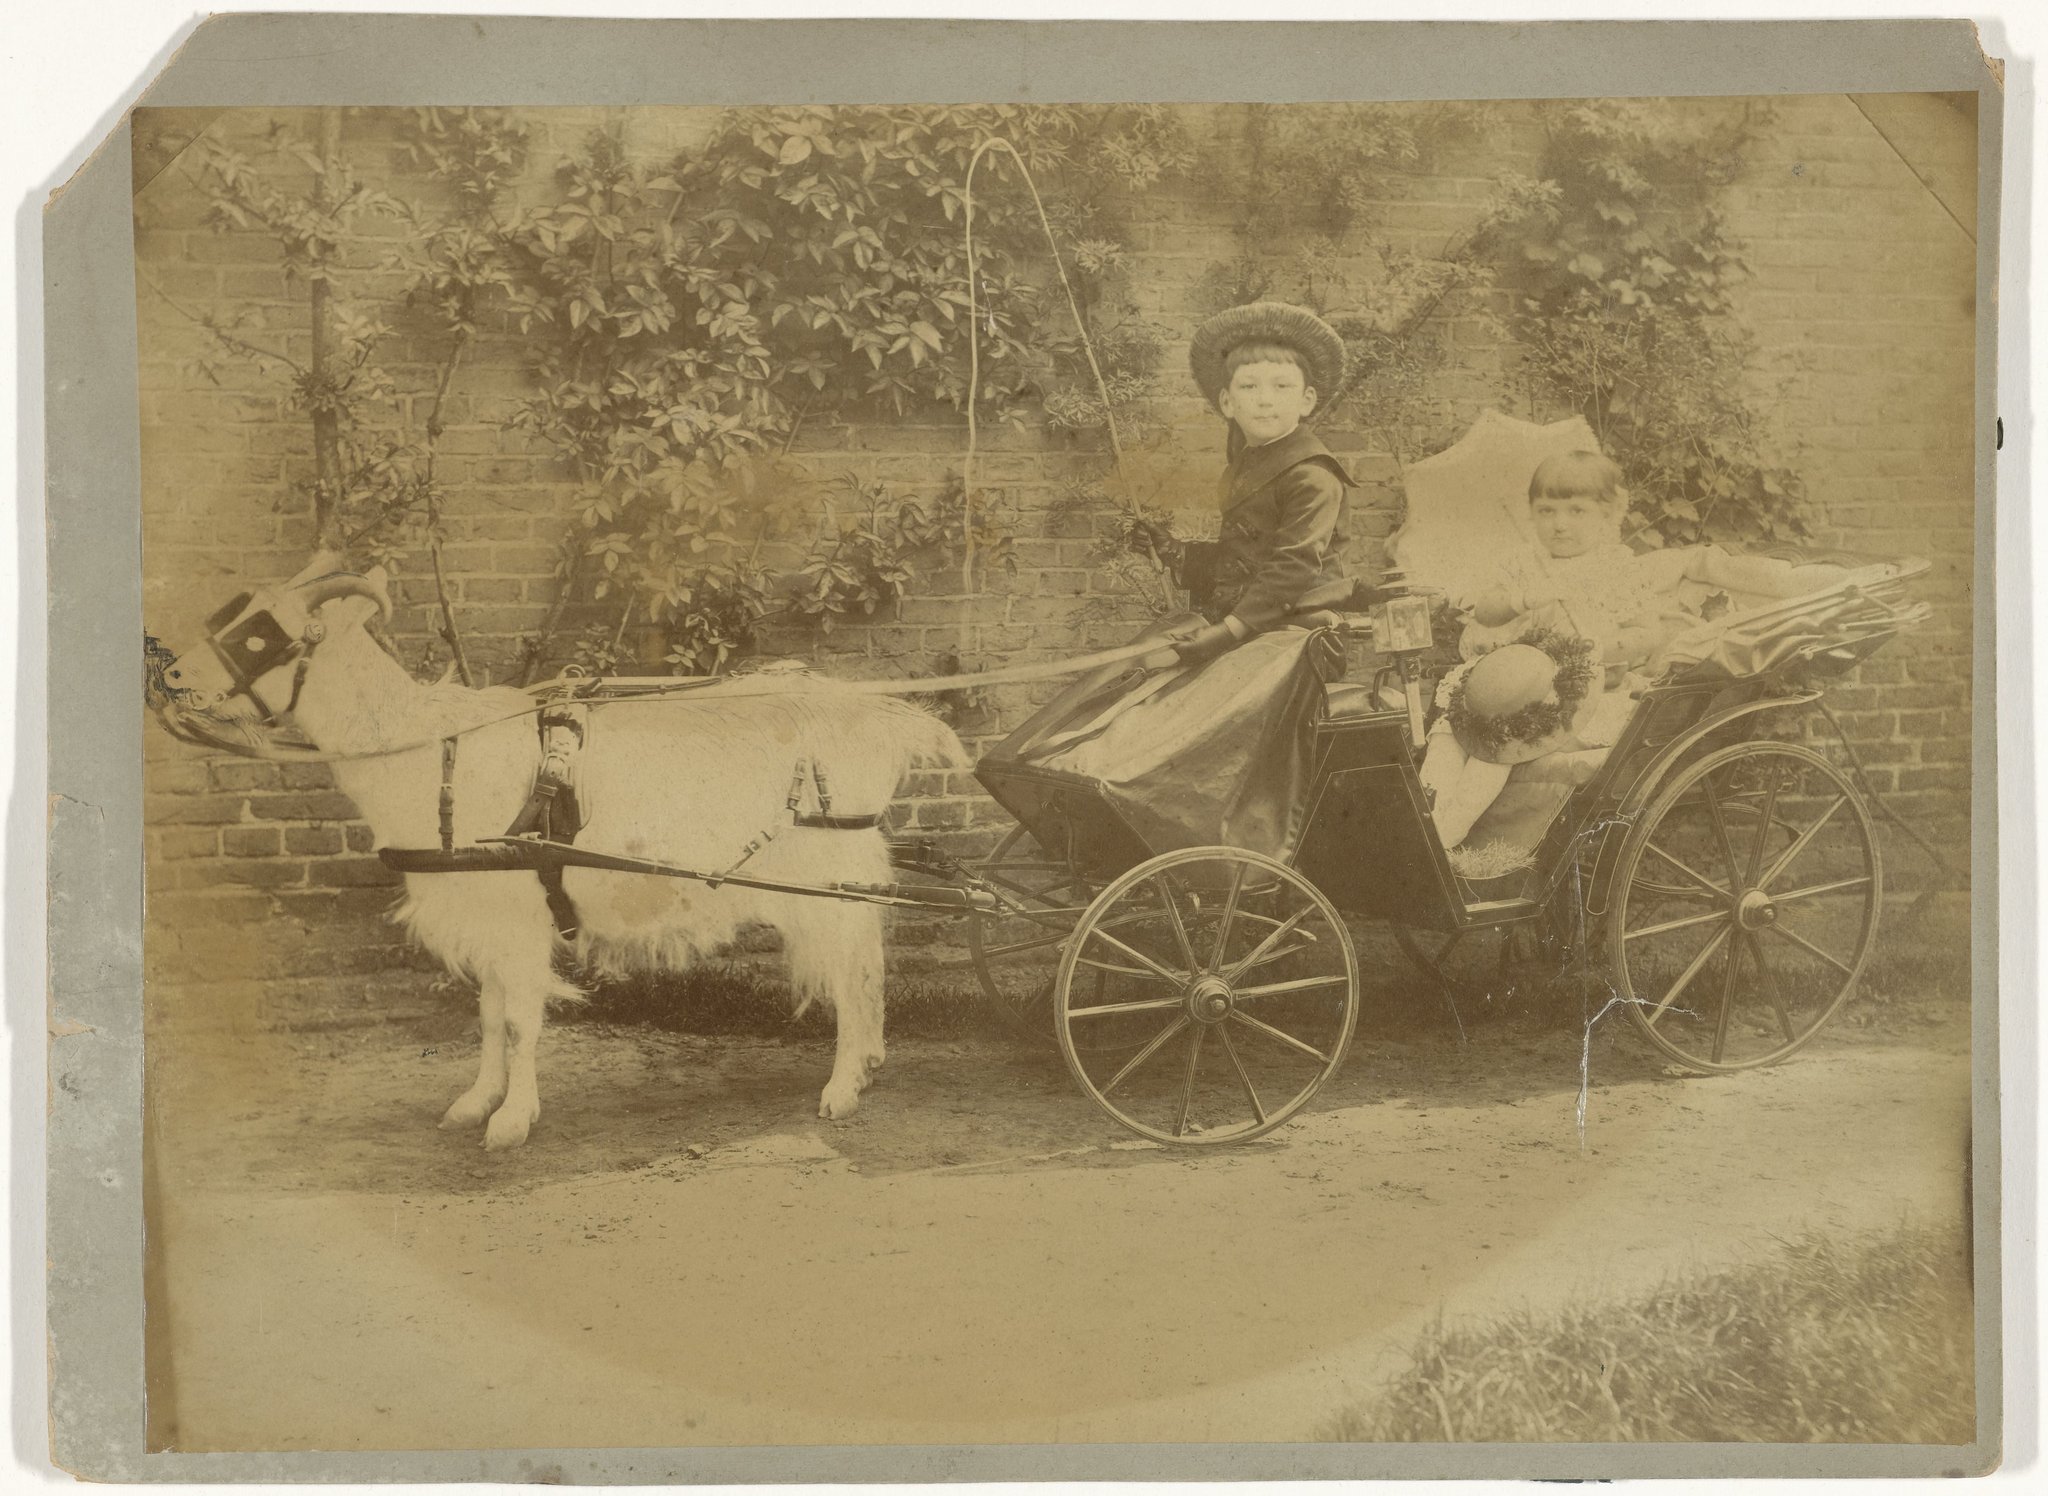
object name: photograph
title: Rijtuig met kinderen getrokken door een bok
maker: Anonymous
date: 1875-1900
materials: cardboard, photographic support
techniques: albumen print